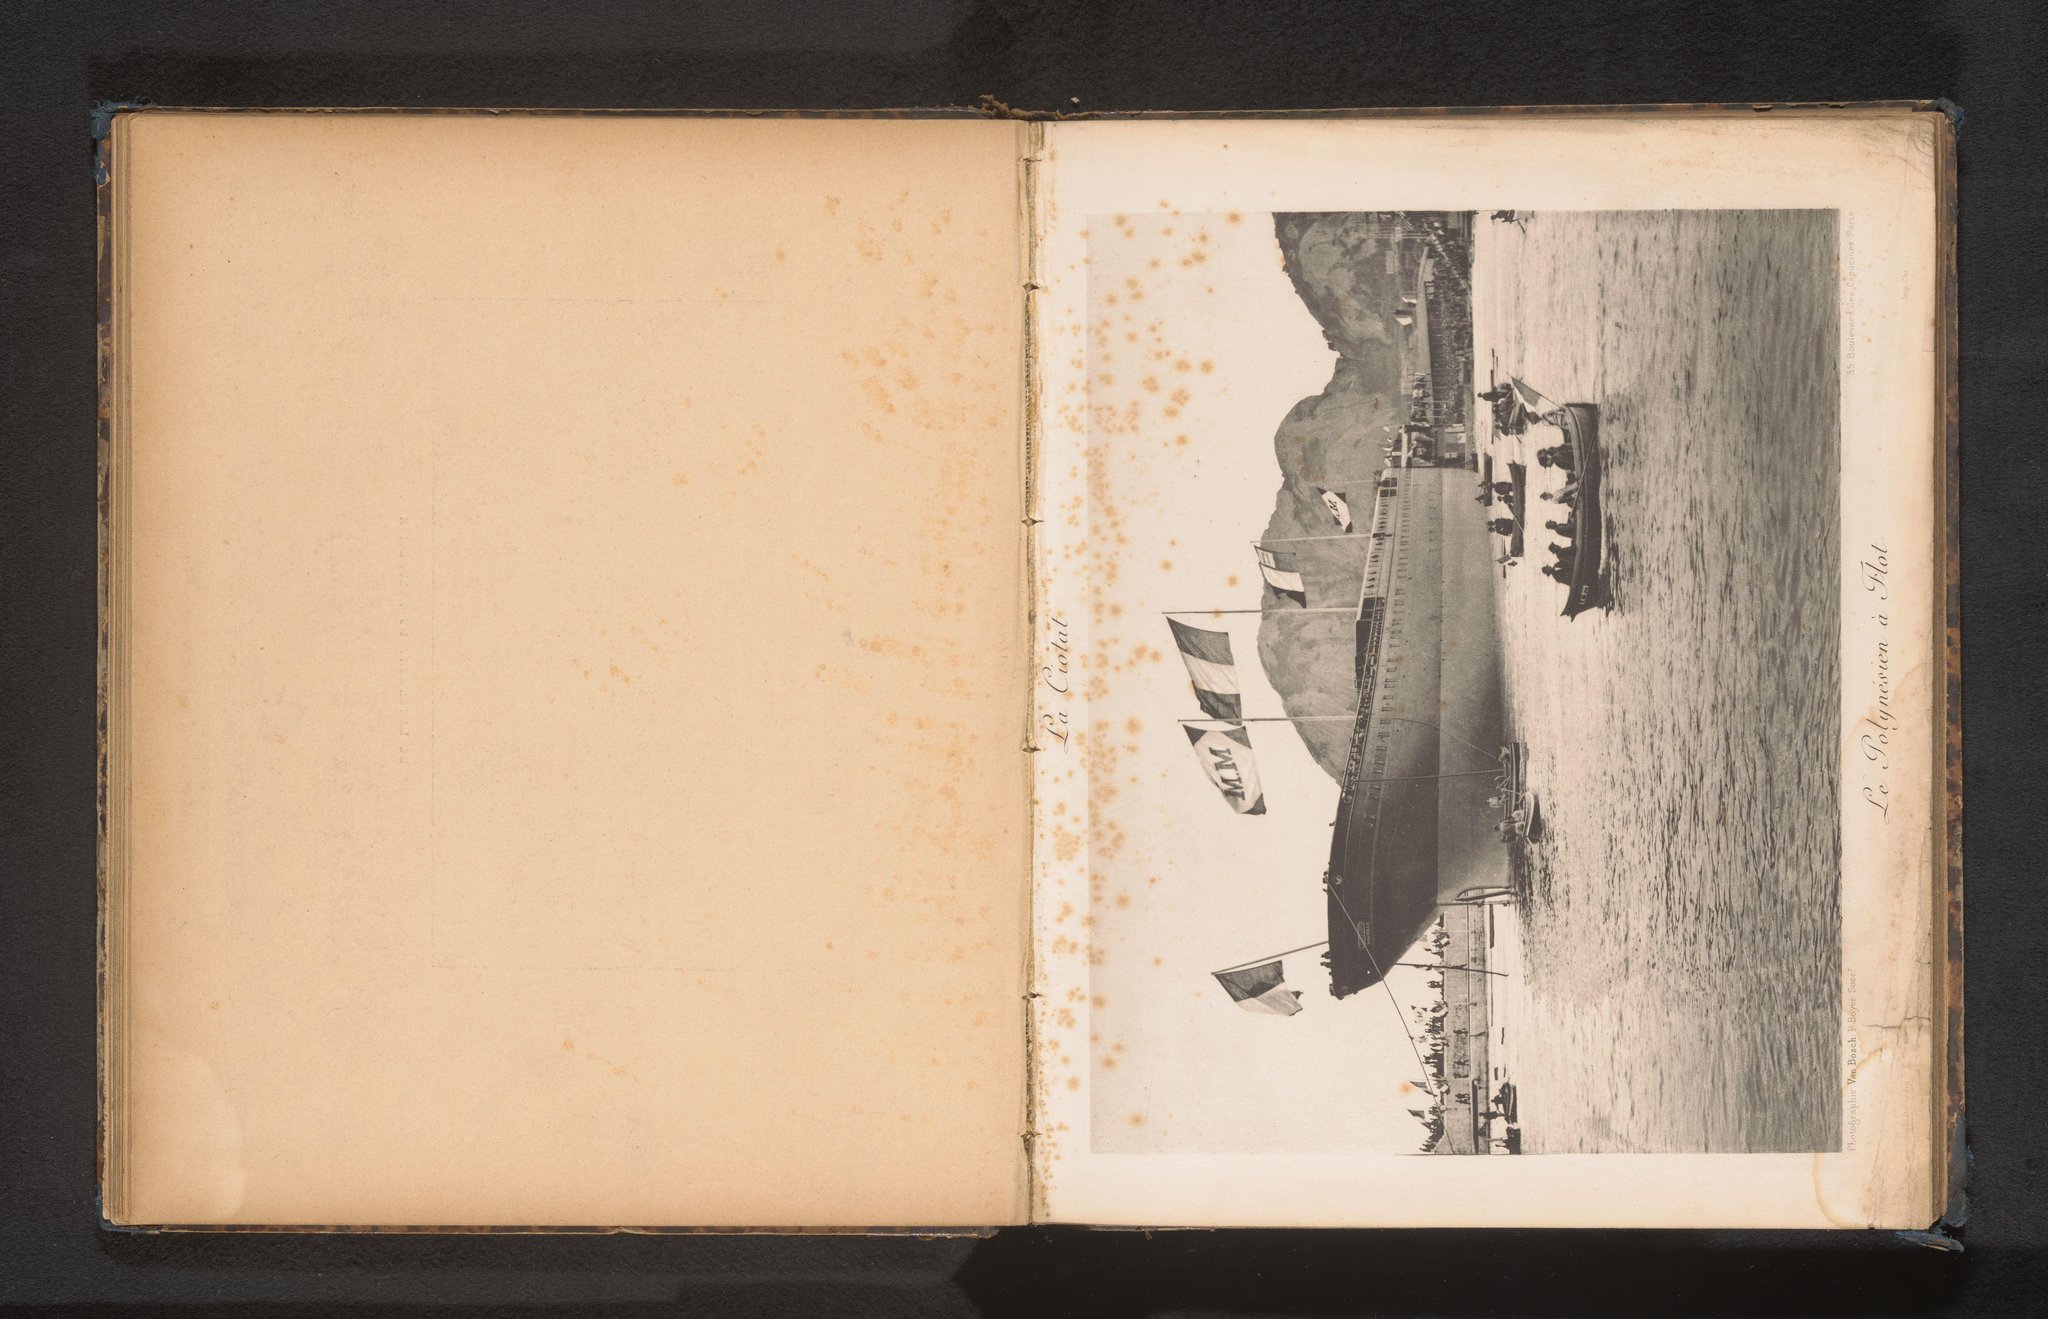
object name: photomechanical print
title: Le Polynésien à flot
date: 1888-1890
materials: paper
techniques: photoaquatint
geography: la ciotat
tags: harbour, ships (in general)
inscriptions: inscription: ‘La Ciotat’, inscription: ‘35 Boulevard des Capucines Paris’